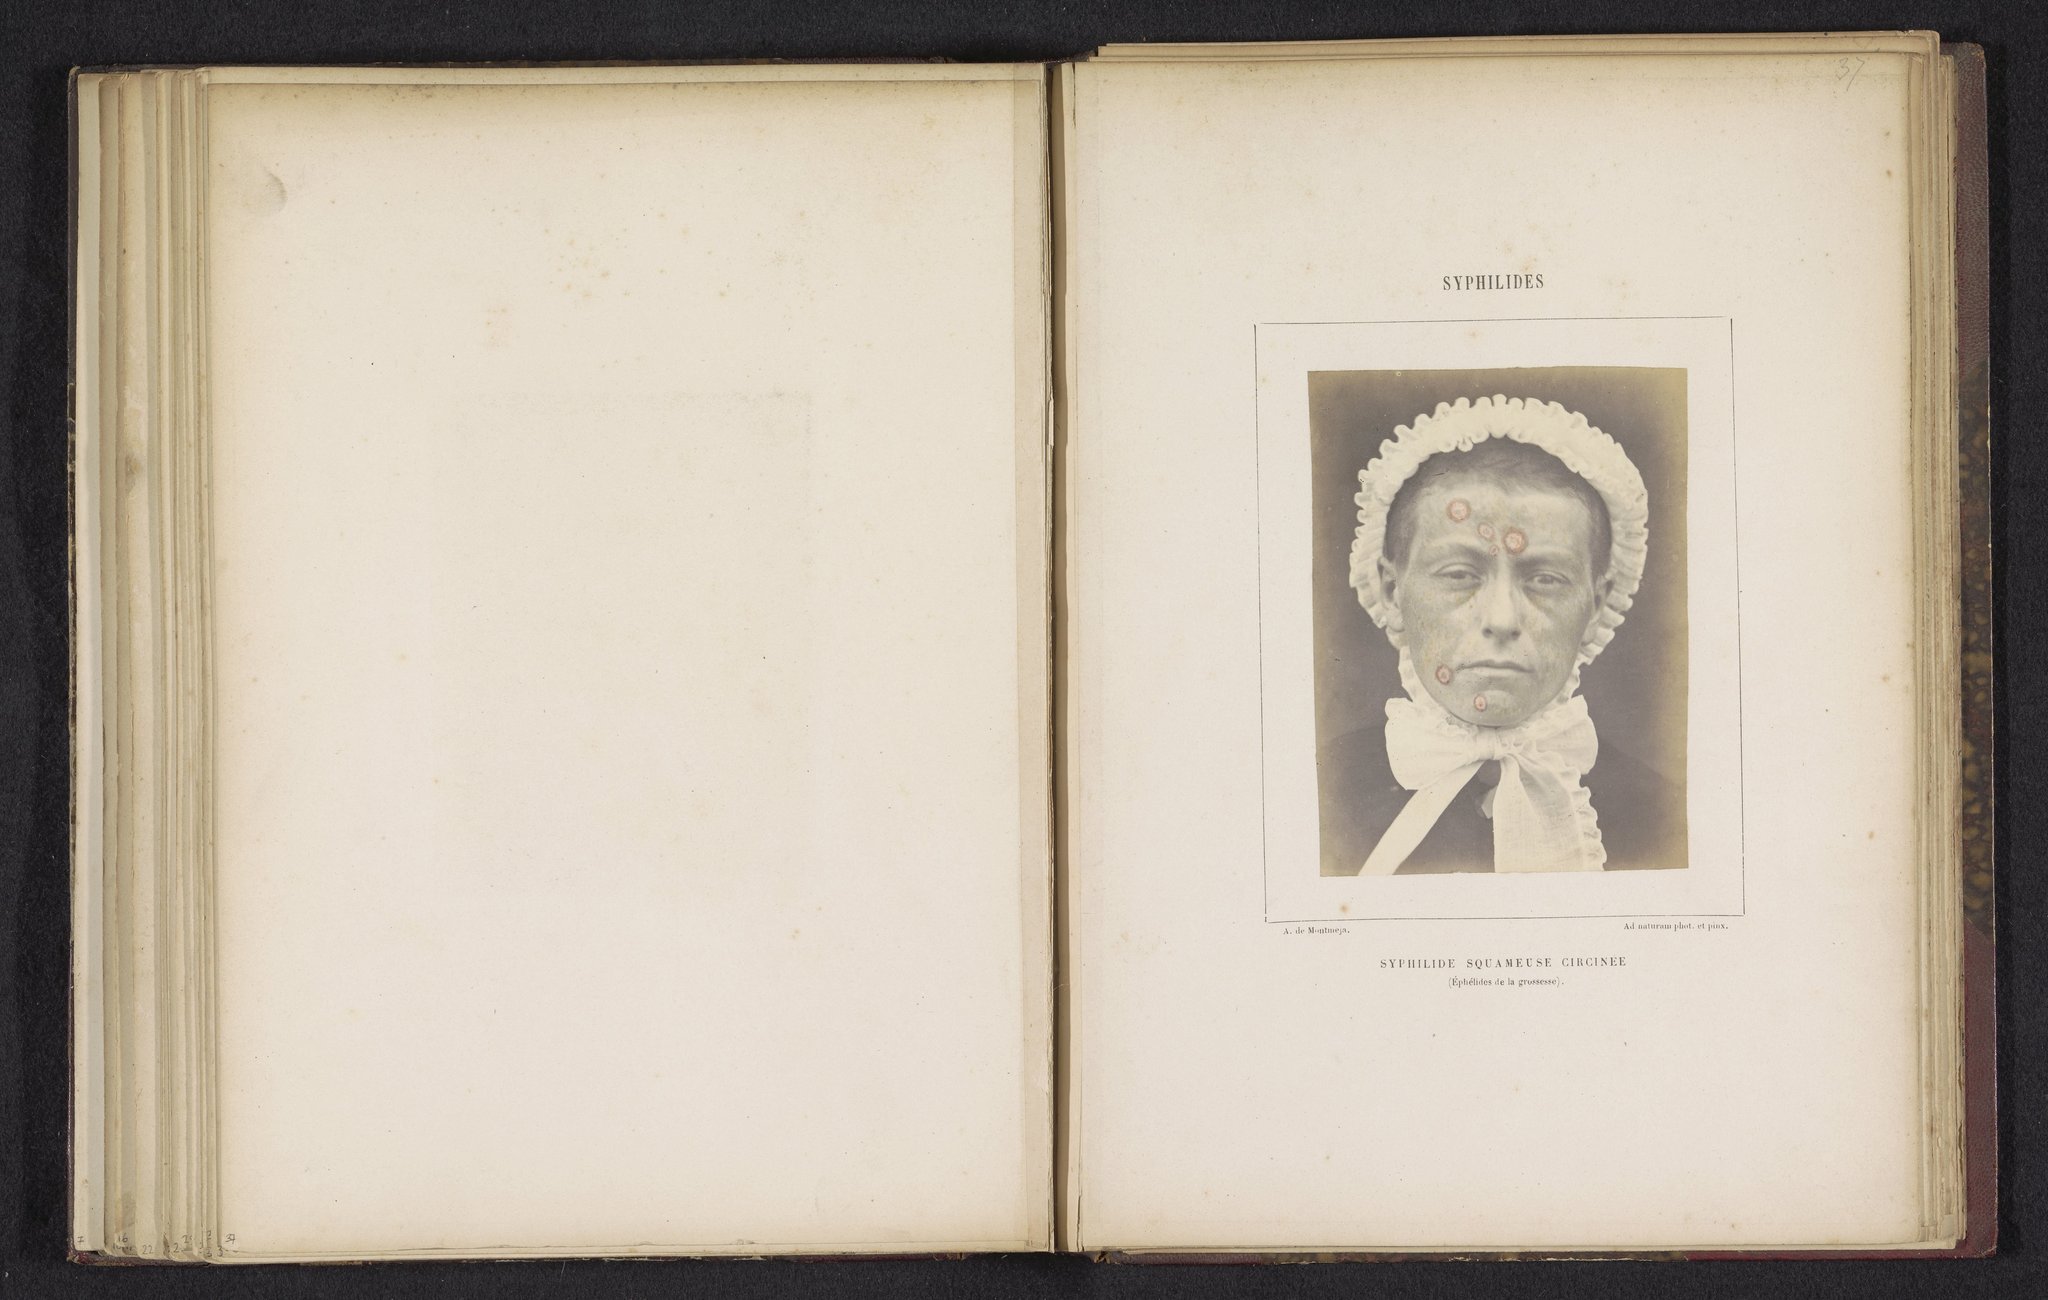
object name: page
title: Portret van een onbekende persoon met huiduitslag veroorzaakt door syfilis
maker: a. de montméja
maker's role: arts, fotograaf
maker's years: 1841-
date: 1860-1868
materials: photographic support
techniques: albumen print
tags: skin and venereal diseases: syphilis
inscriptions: inscription: ‘Syphilides’, number: ‘37’, inscription: ‘Ad naturam phot. et pinx.’